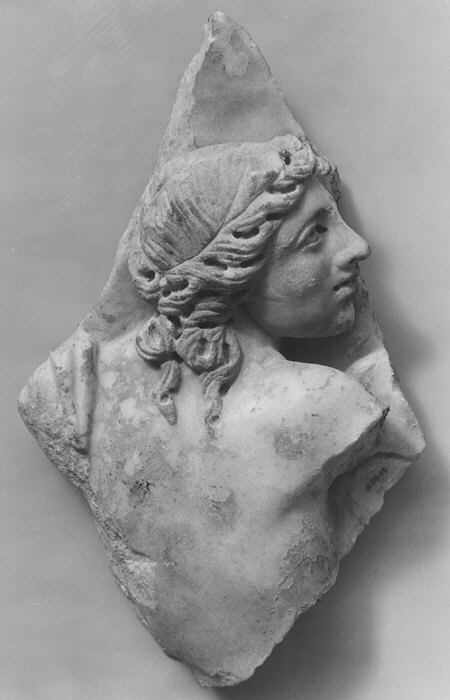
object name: sarcophagus fragment, nereid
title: Marble sarcophagus fragment: female figure, perhaps a nereid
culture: roman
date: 200-235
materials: marble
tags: heads,female nudes